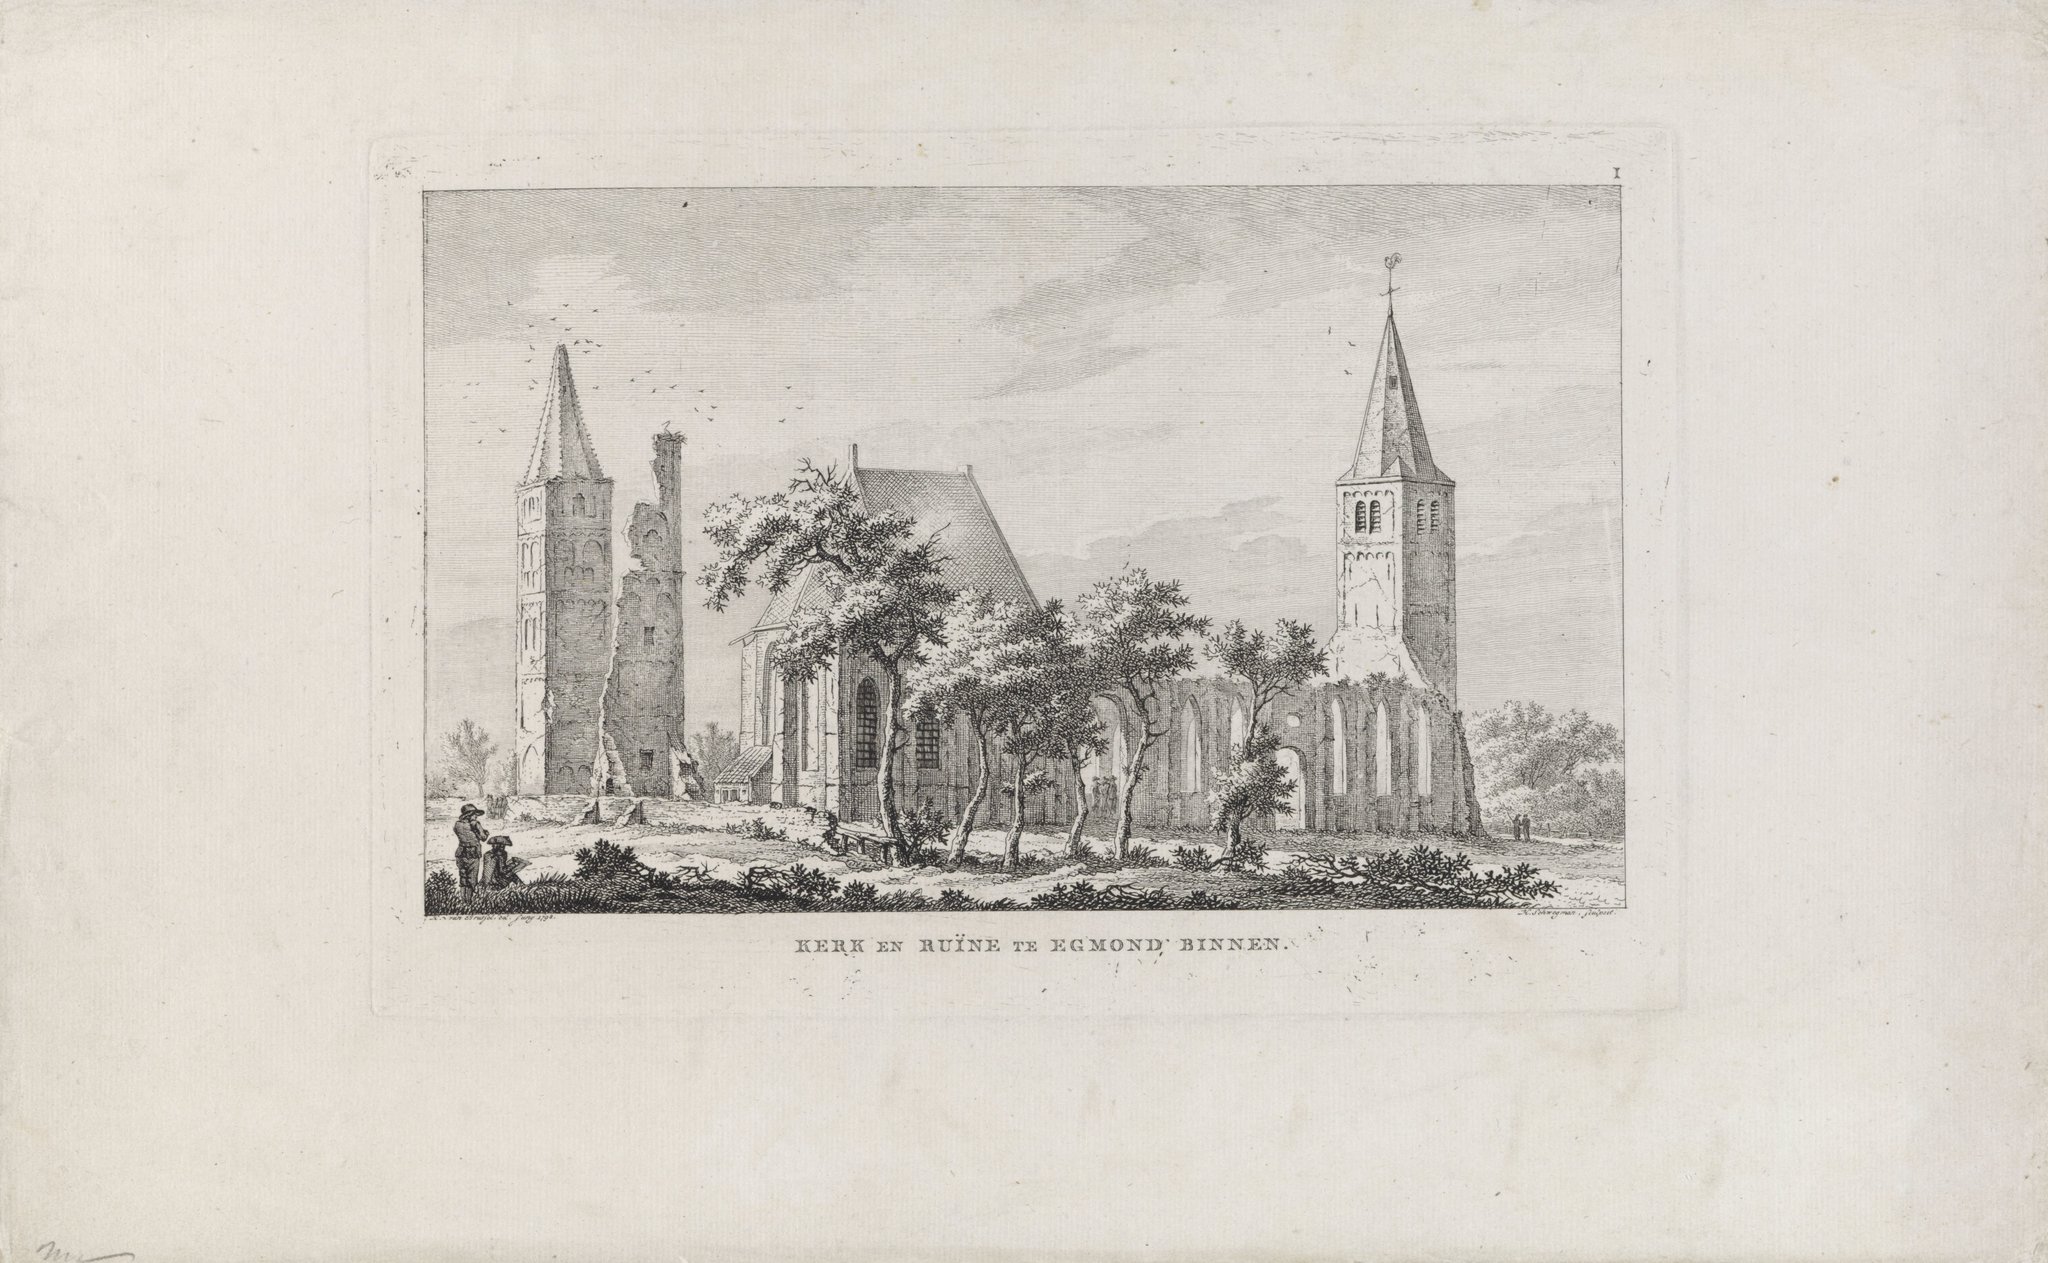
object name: print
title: Toren van de Abdijkerk te Egmond, in welstand, 1798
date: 1799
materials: paper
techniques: engraving, etching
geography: netherlands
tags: ruin of church, monastery, etc., draughtsman at work - cc - out of doors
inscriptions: collector's mark: Lugt 2228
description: Gezicht op de ruïne van de Abdijkerk met toren te Egmond-Binnen, in welstand in juni 1798 vóór het instorten op 18 december 1798. Links op de voorgrond een zittende tekenaar. Genummerd rechtsboven: I. Zie pendant.